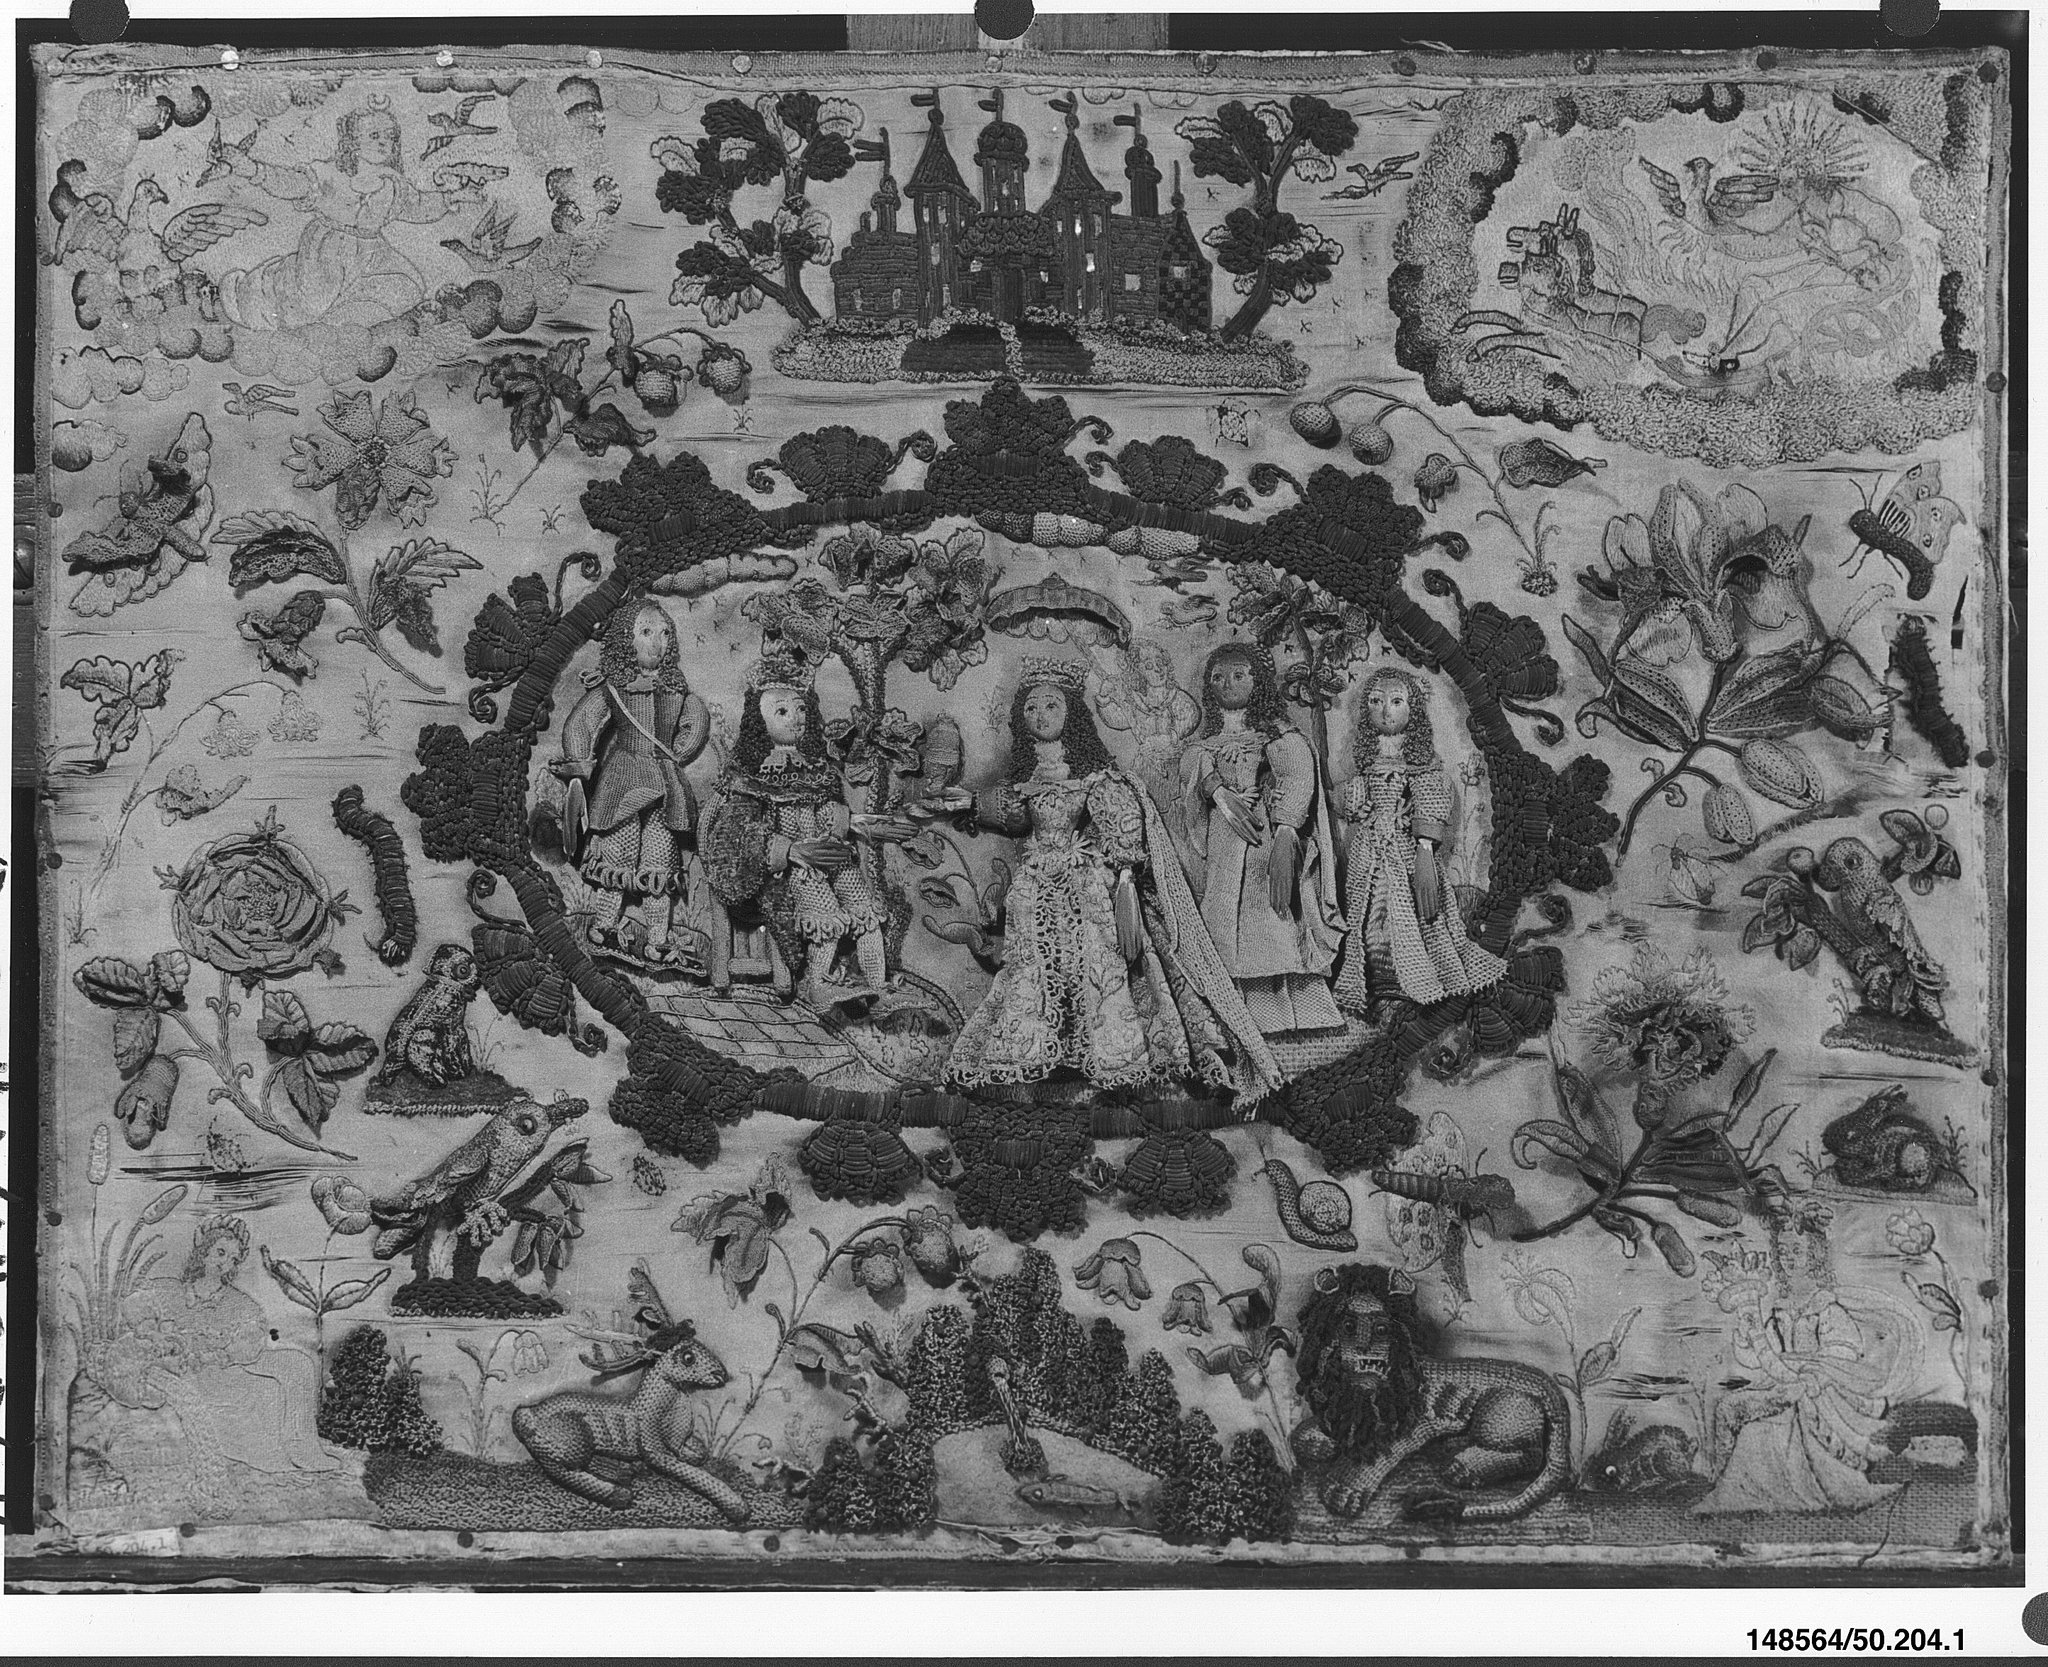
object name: embroidered picture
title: Picture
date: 1651-1675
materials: silk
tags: birds,castles,men,women,deer,butterflies,snails,lions,flowers